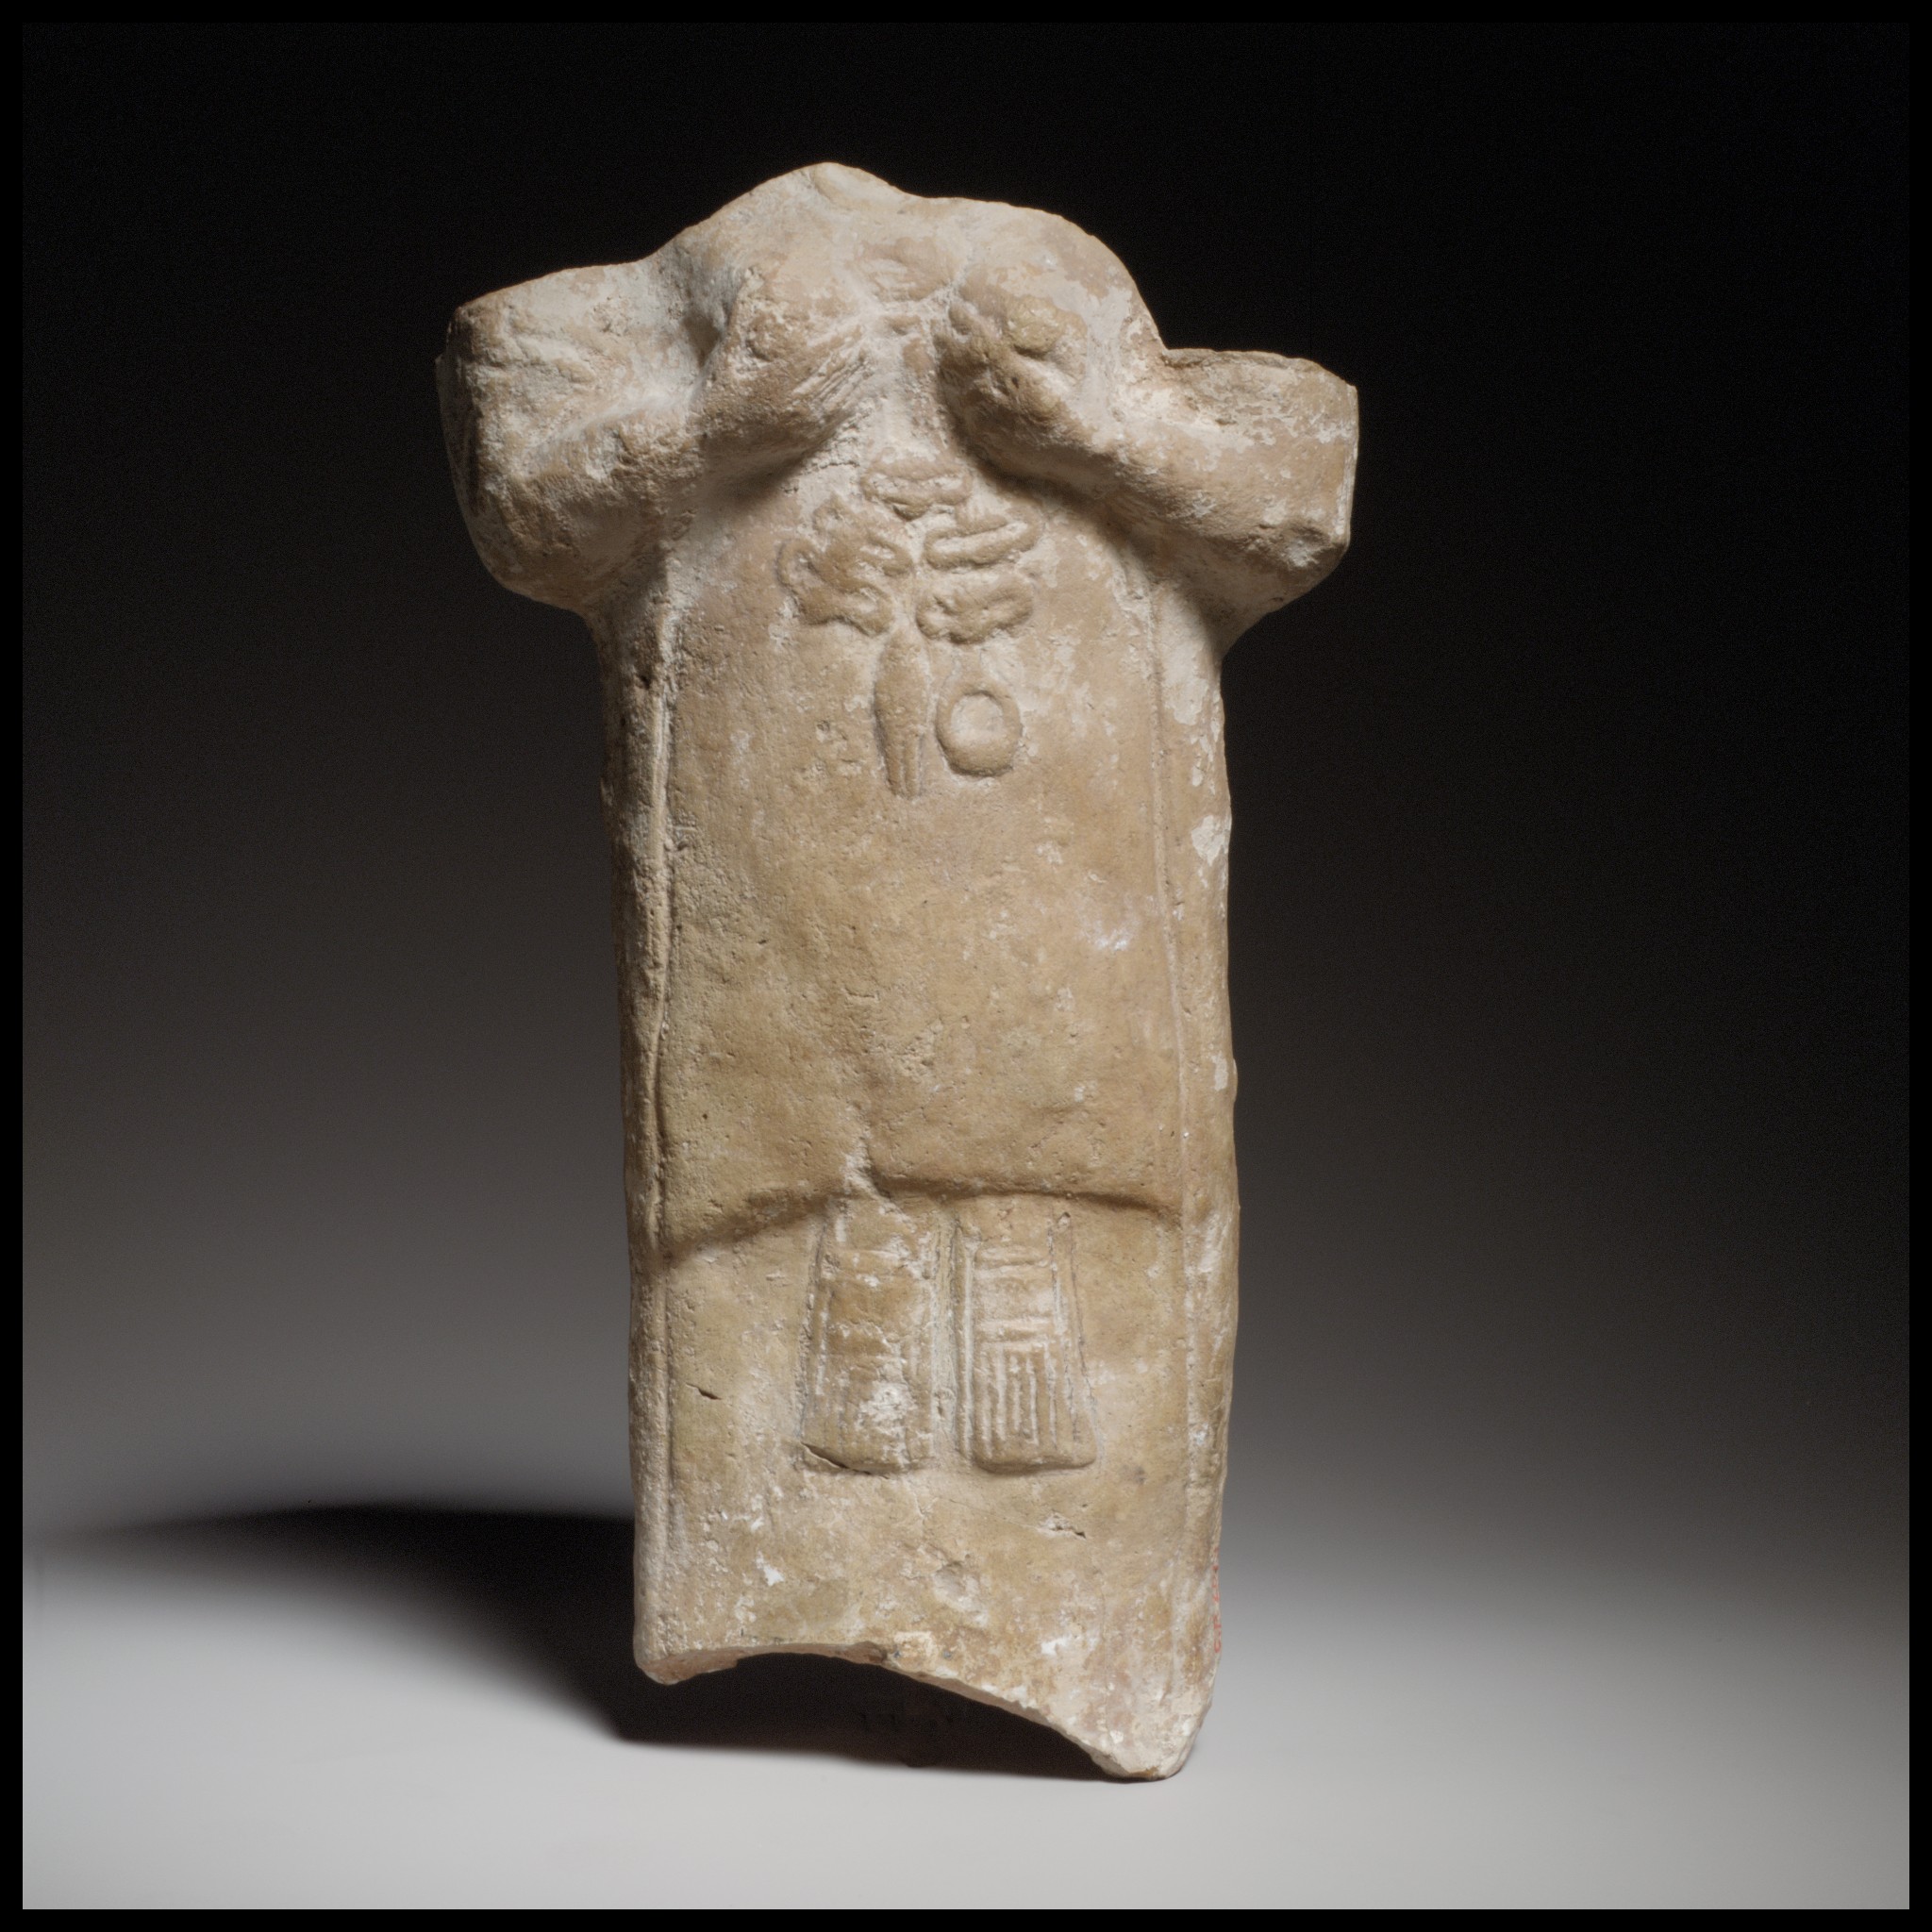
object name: statuette of a woman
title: Terracotta statuette of a woman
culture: cypriot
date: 600-501 BCE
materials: terracotta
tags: women